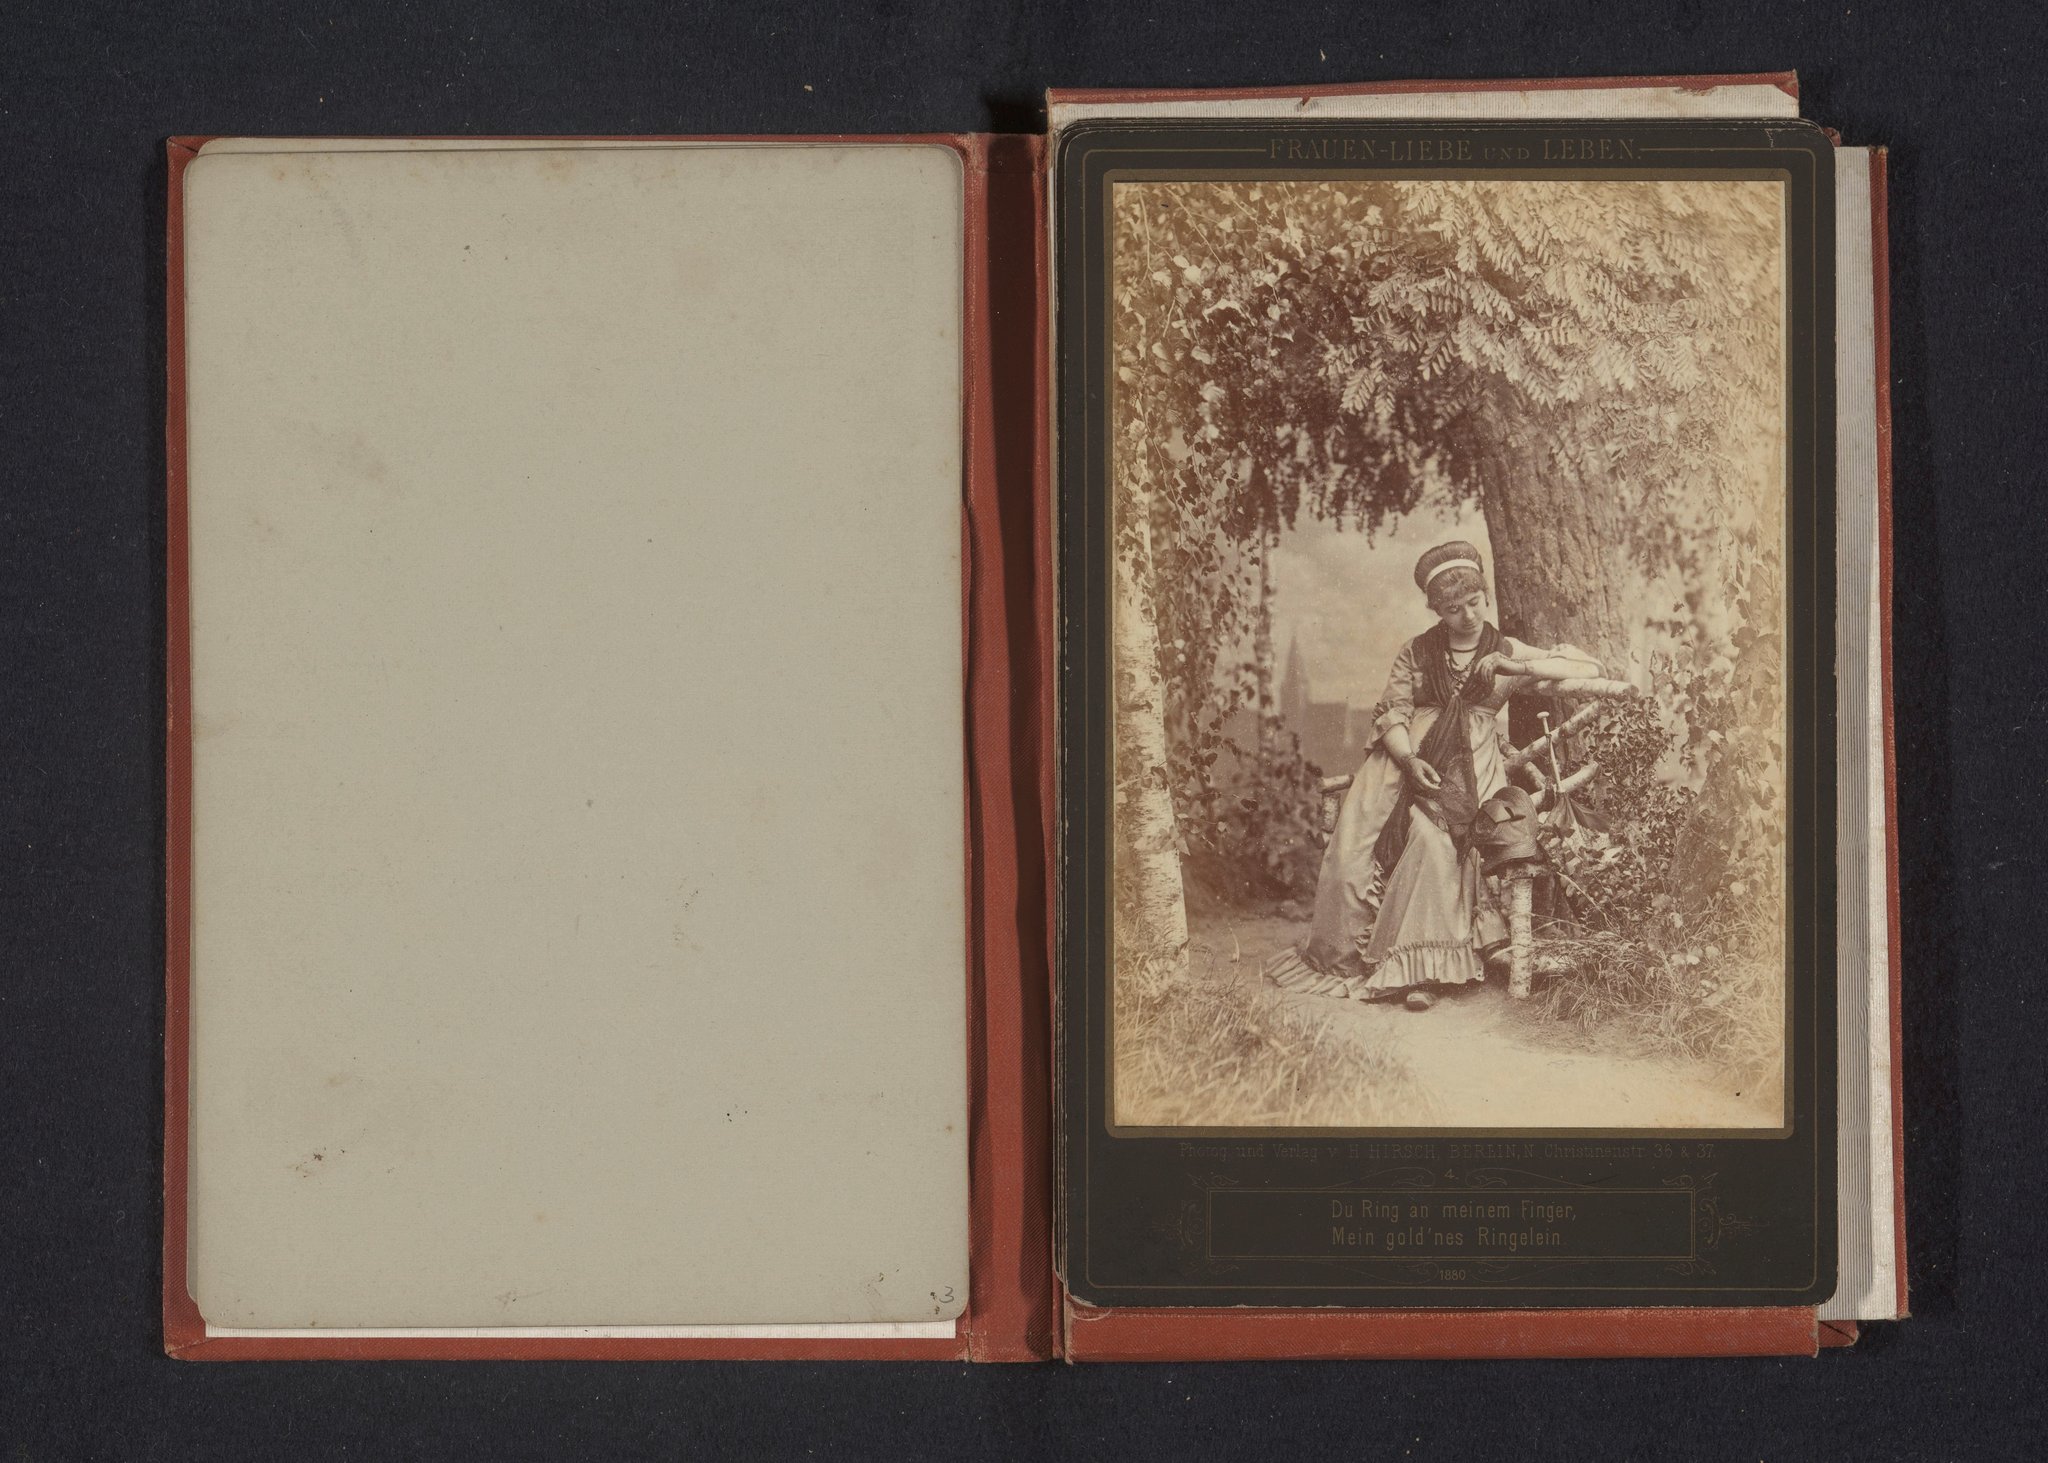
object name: page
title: Frauen-Liebe und Leben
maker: hugo hirsch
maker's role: publisher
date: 1880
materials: photographic support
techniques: albumen print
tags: bench, adult woman, ring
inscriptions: number: ‘4.’, name: ‘Photog. und Verlag v. H. Hirsch, Berlin, N Christinenstr. 36 & 37’